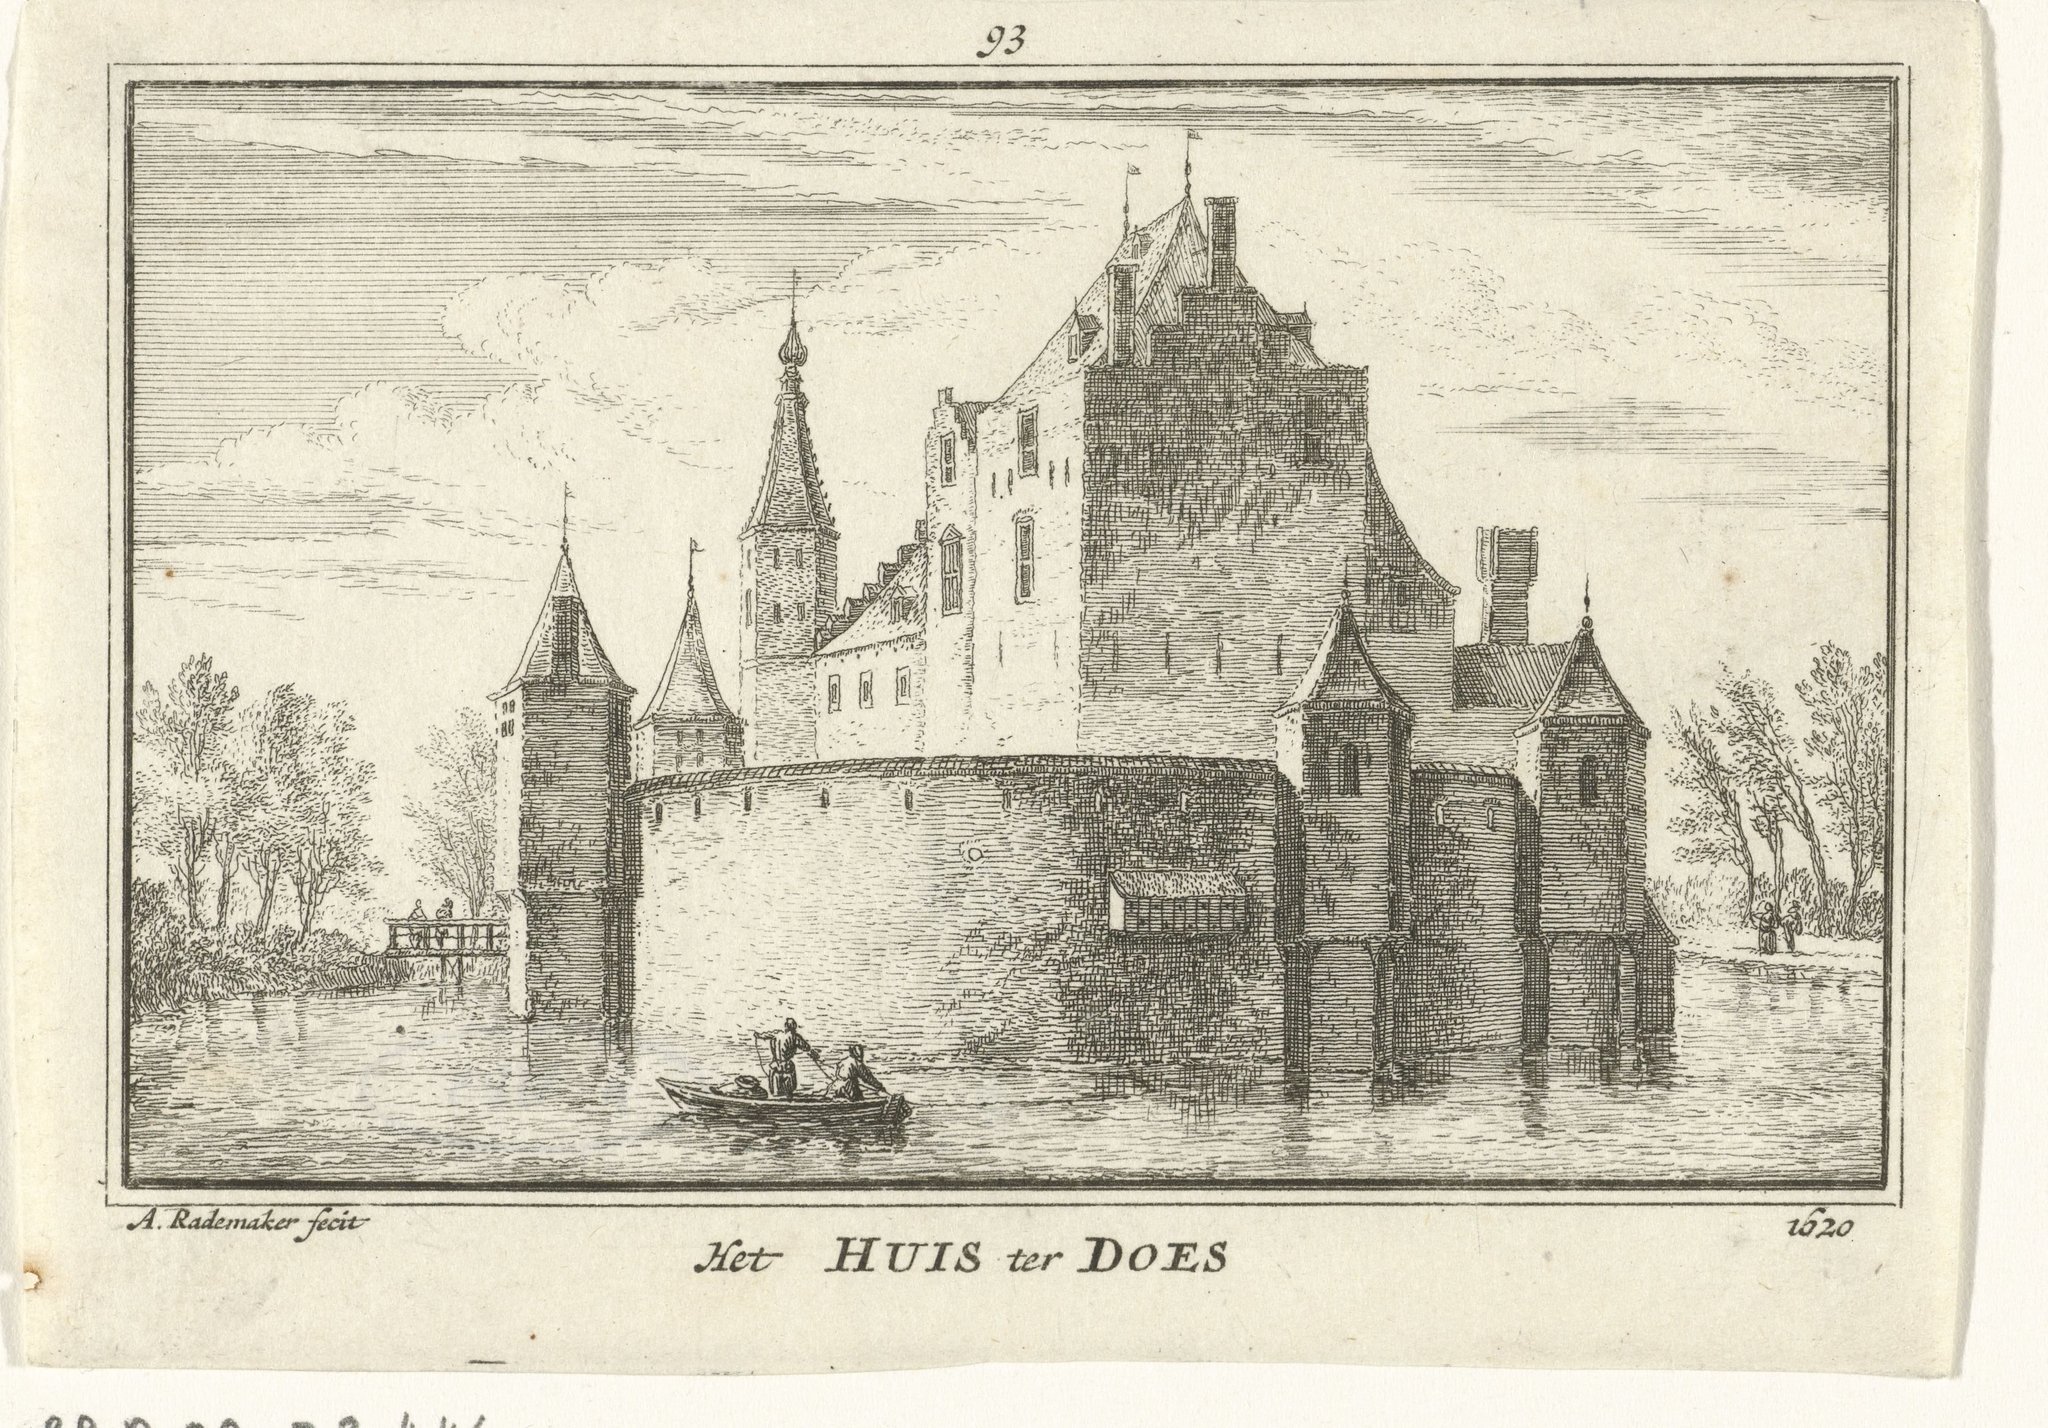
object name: book illustration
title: Het Huis ter Does 1620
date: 1727-1733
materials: paper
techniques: etching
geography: amsterdam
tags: castle, fisherman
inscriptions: collector's mark: Lugt 2228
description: Illustratie uit: Abraham Rademaker, Matthaeus Brouërius van Niedek, Isaac Le Long, Kabinet van Nederlandsche en Kleefsche outheden en (...) voorname stads- en landgebouwen, Willem Barents en Antoni Schoonenburg: Amsterdam, 1727-1733, ill. nr. 93.